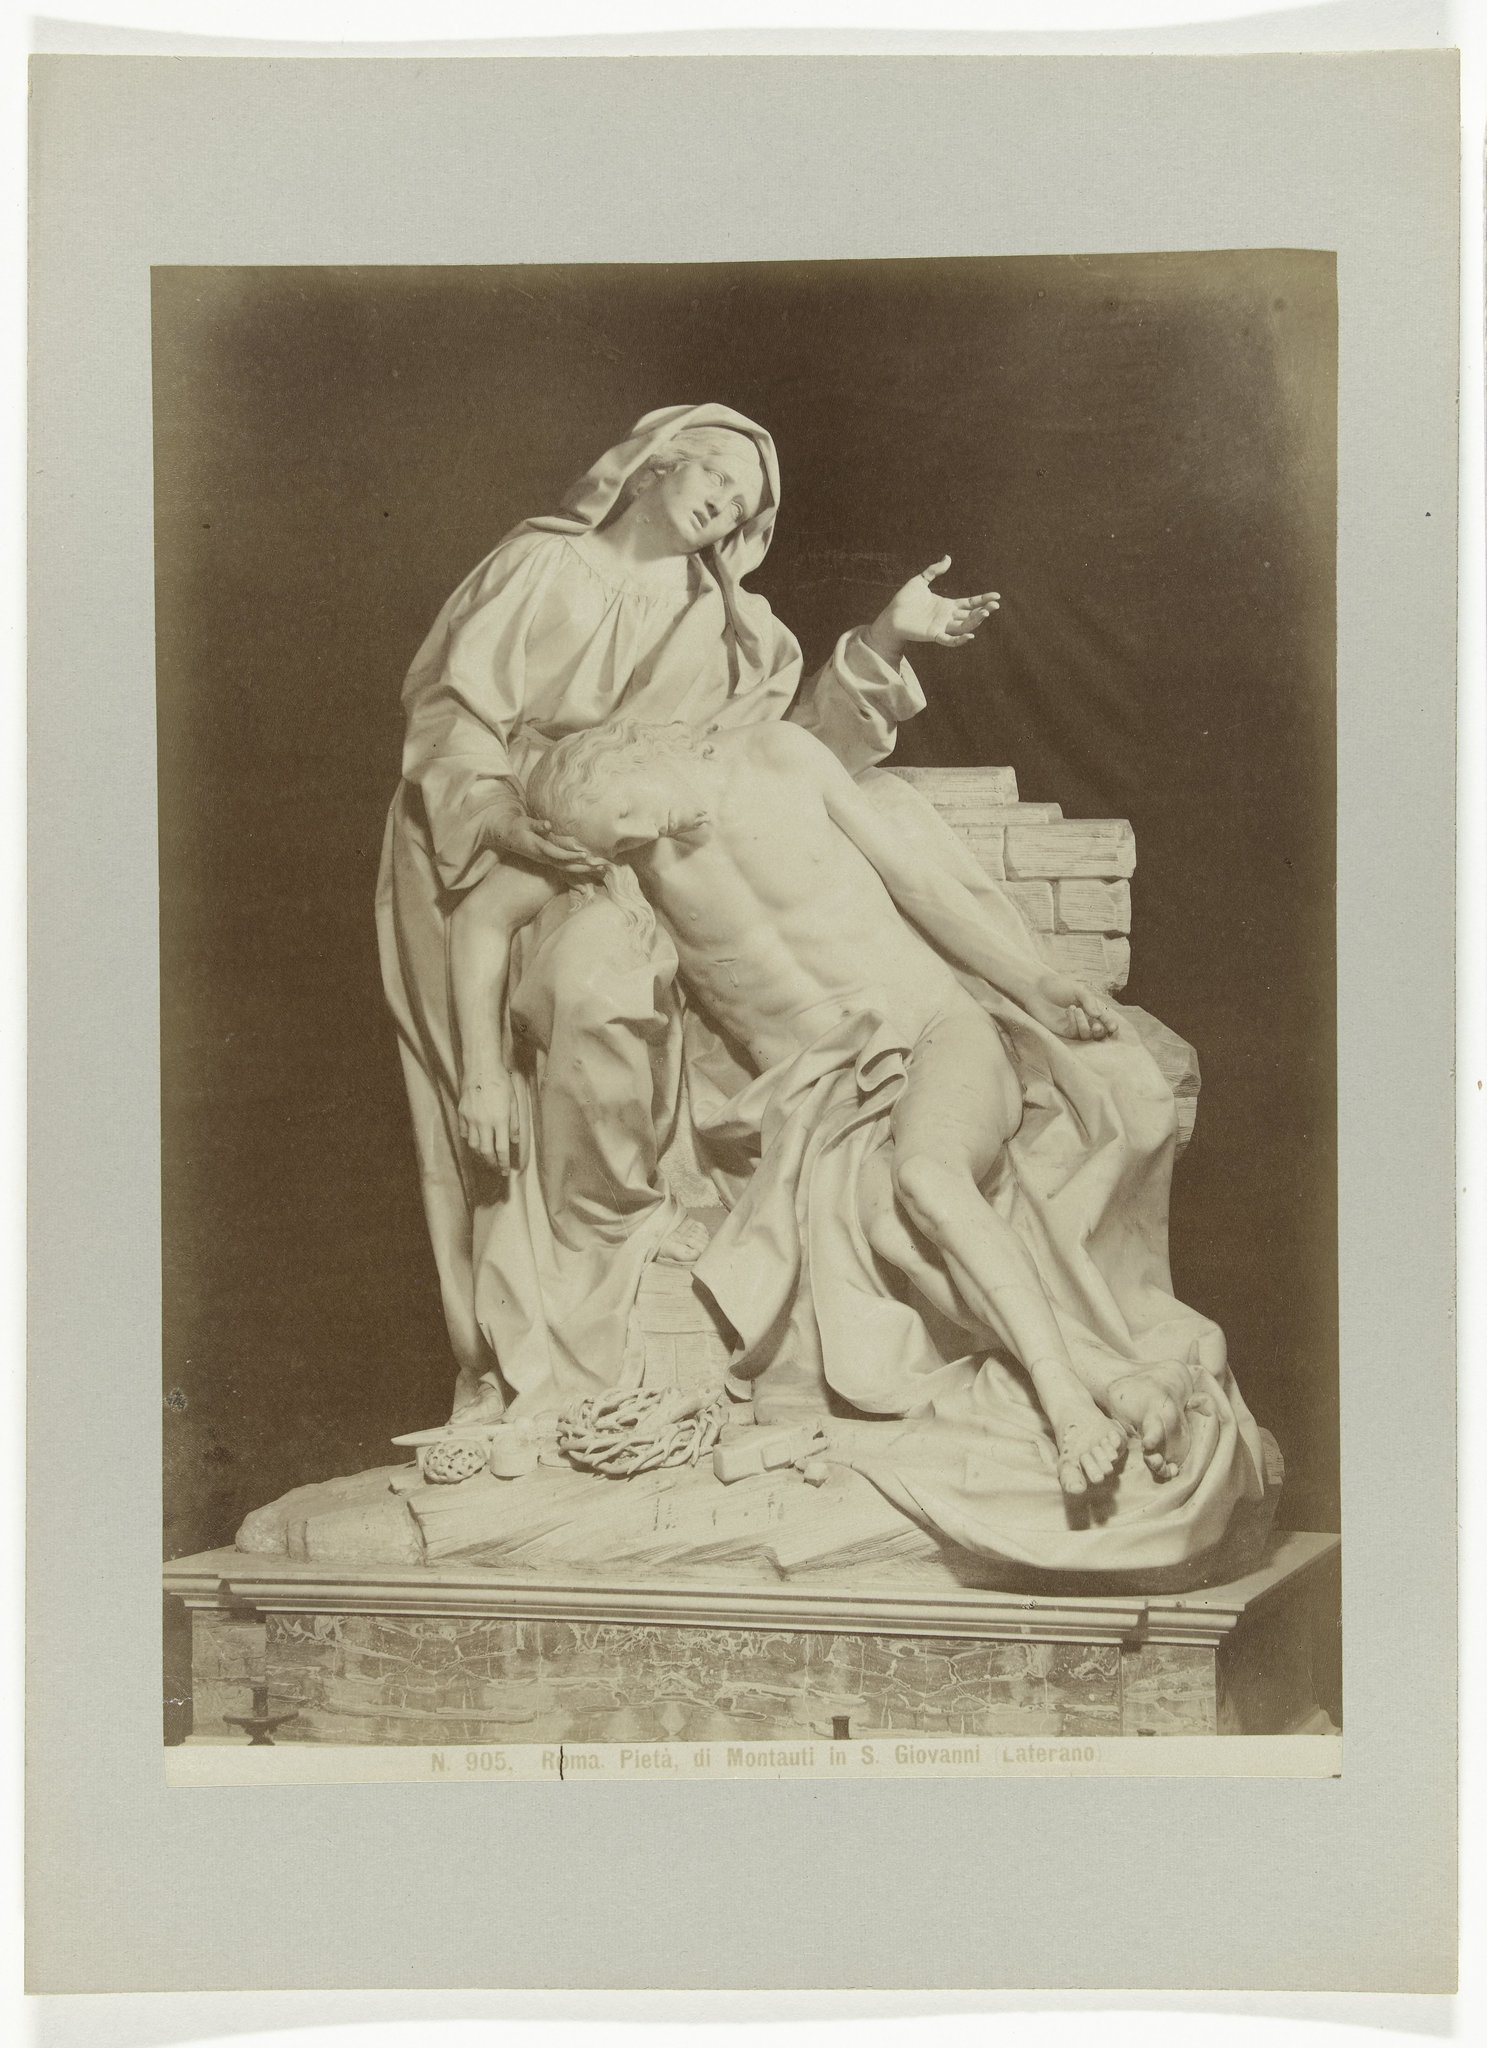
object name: photograph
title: N. 905, Roma. Pietà, di Montauti in S. Giovanni (Laterano)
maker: Anonymous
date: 1880-1904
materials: cardboard, paper, photographic support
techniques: albumen print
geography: rome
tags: sint-jan van lateranen